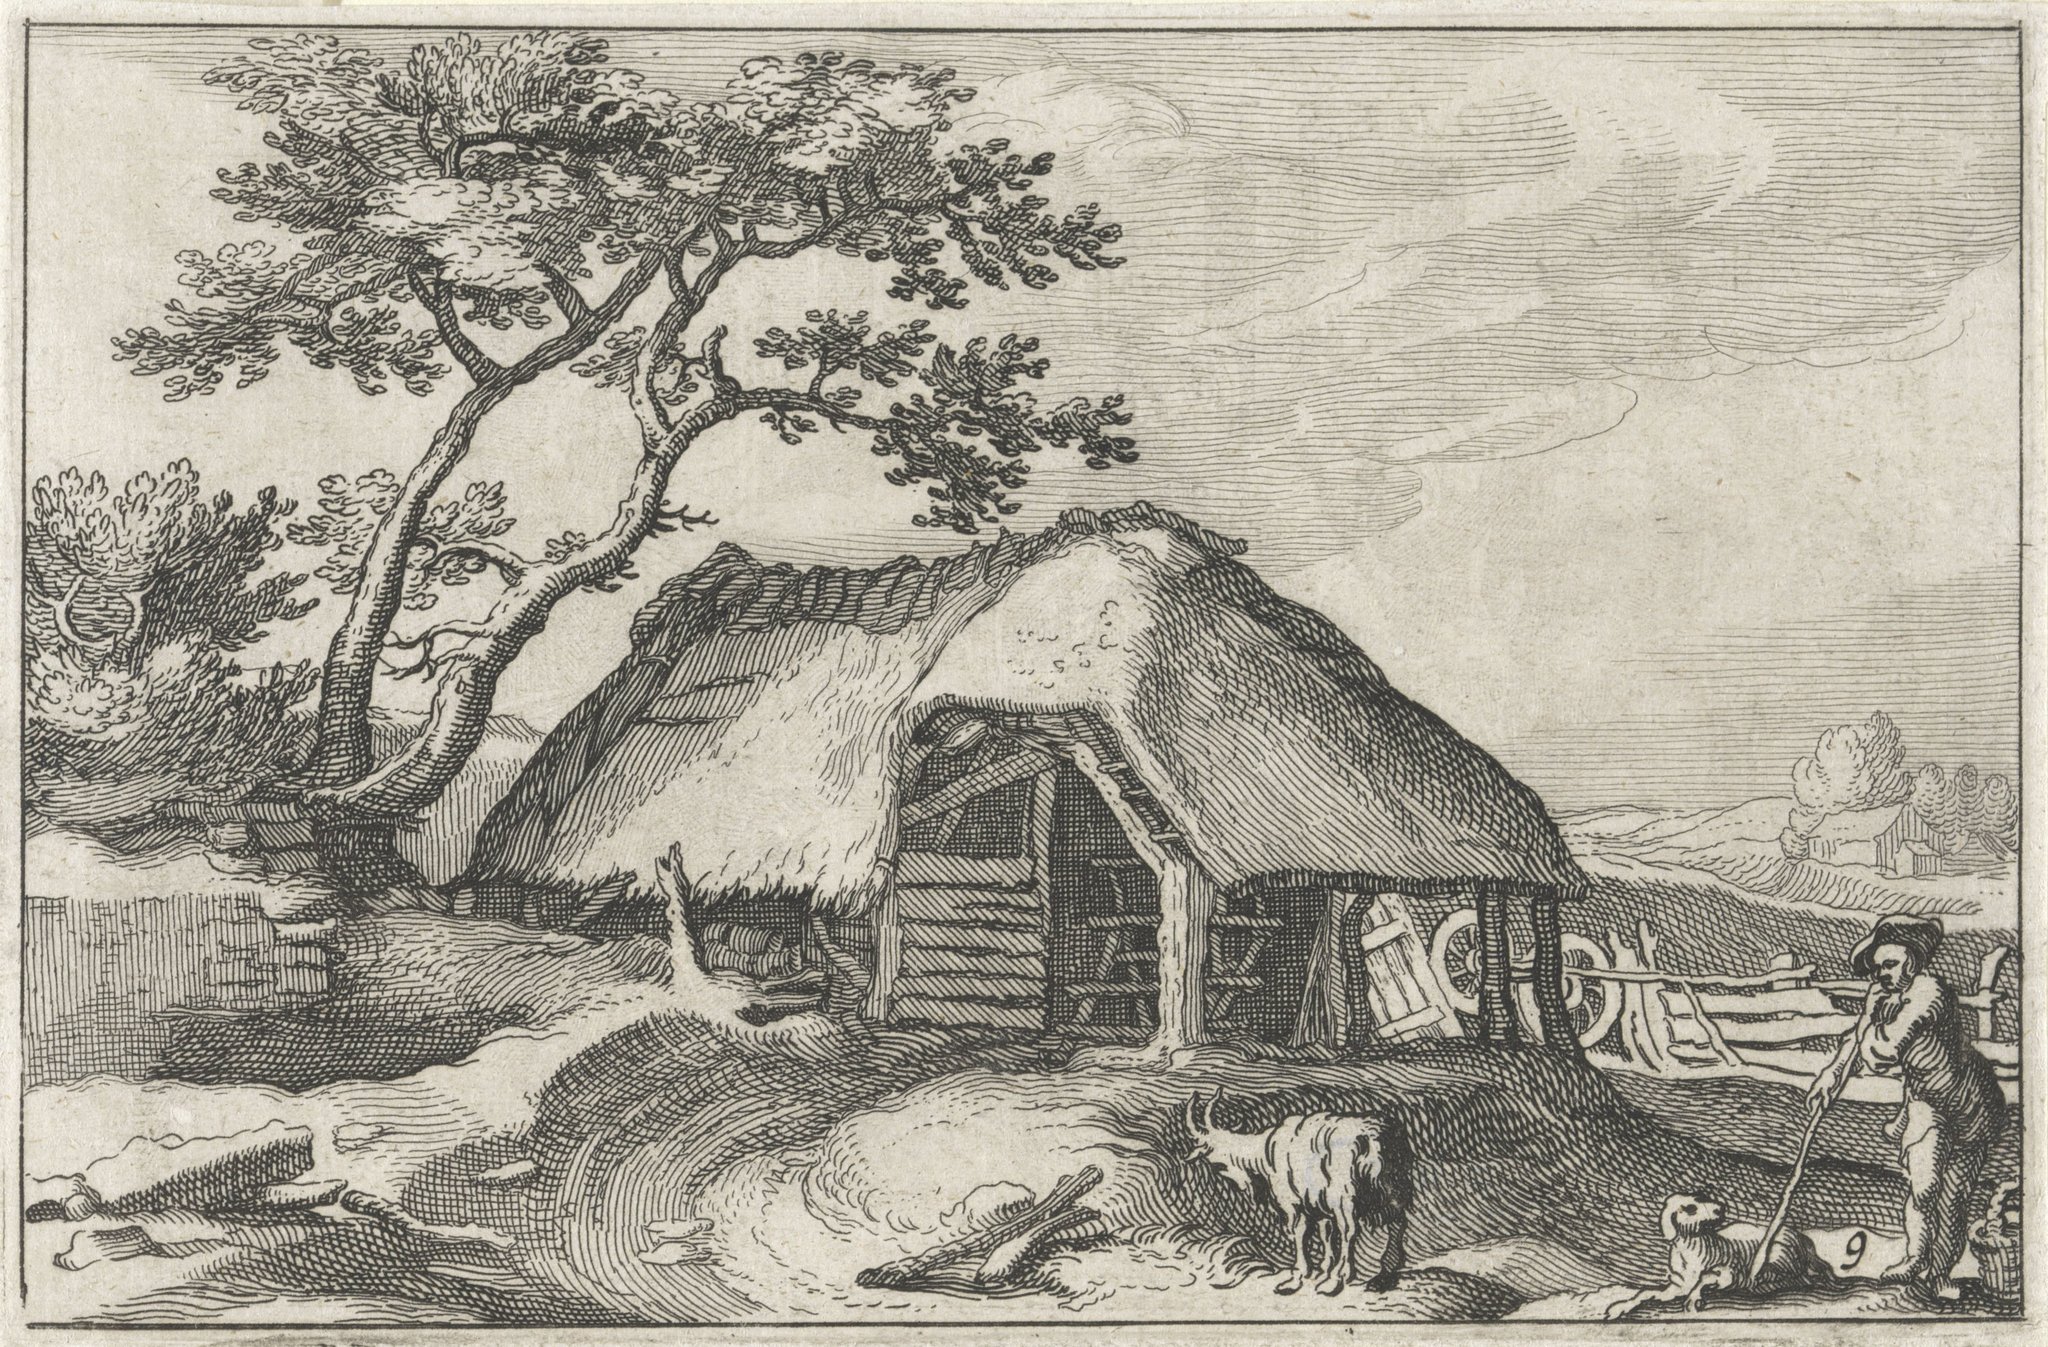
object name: print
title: Landschappen met boerderijen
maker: claes jansz. visscher (ii)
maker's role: draughtsman, print maker, publisher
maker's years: 1586-1652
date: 1620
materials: paper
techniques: etching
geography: amsterdam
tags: barn, herding, herdsman, herdswoman, shepherd, shepherdess, cowherd, etc., farm or solitary house in landscape, dog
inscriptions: number: ‘9’ Lugt, collector's mark: 2228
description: Gezicht op een landschap met een boerderij waar een herder met zijn hond en geit bij staan. Op de achtergrond een tweede boerenhoeve.